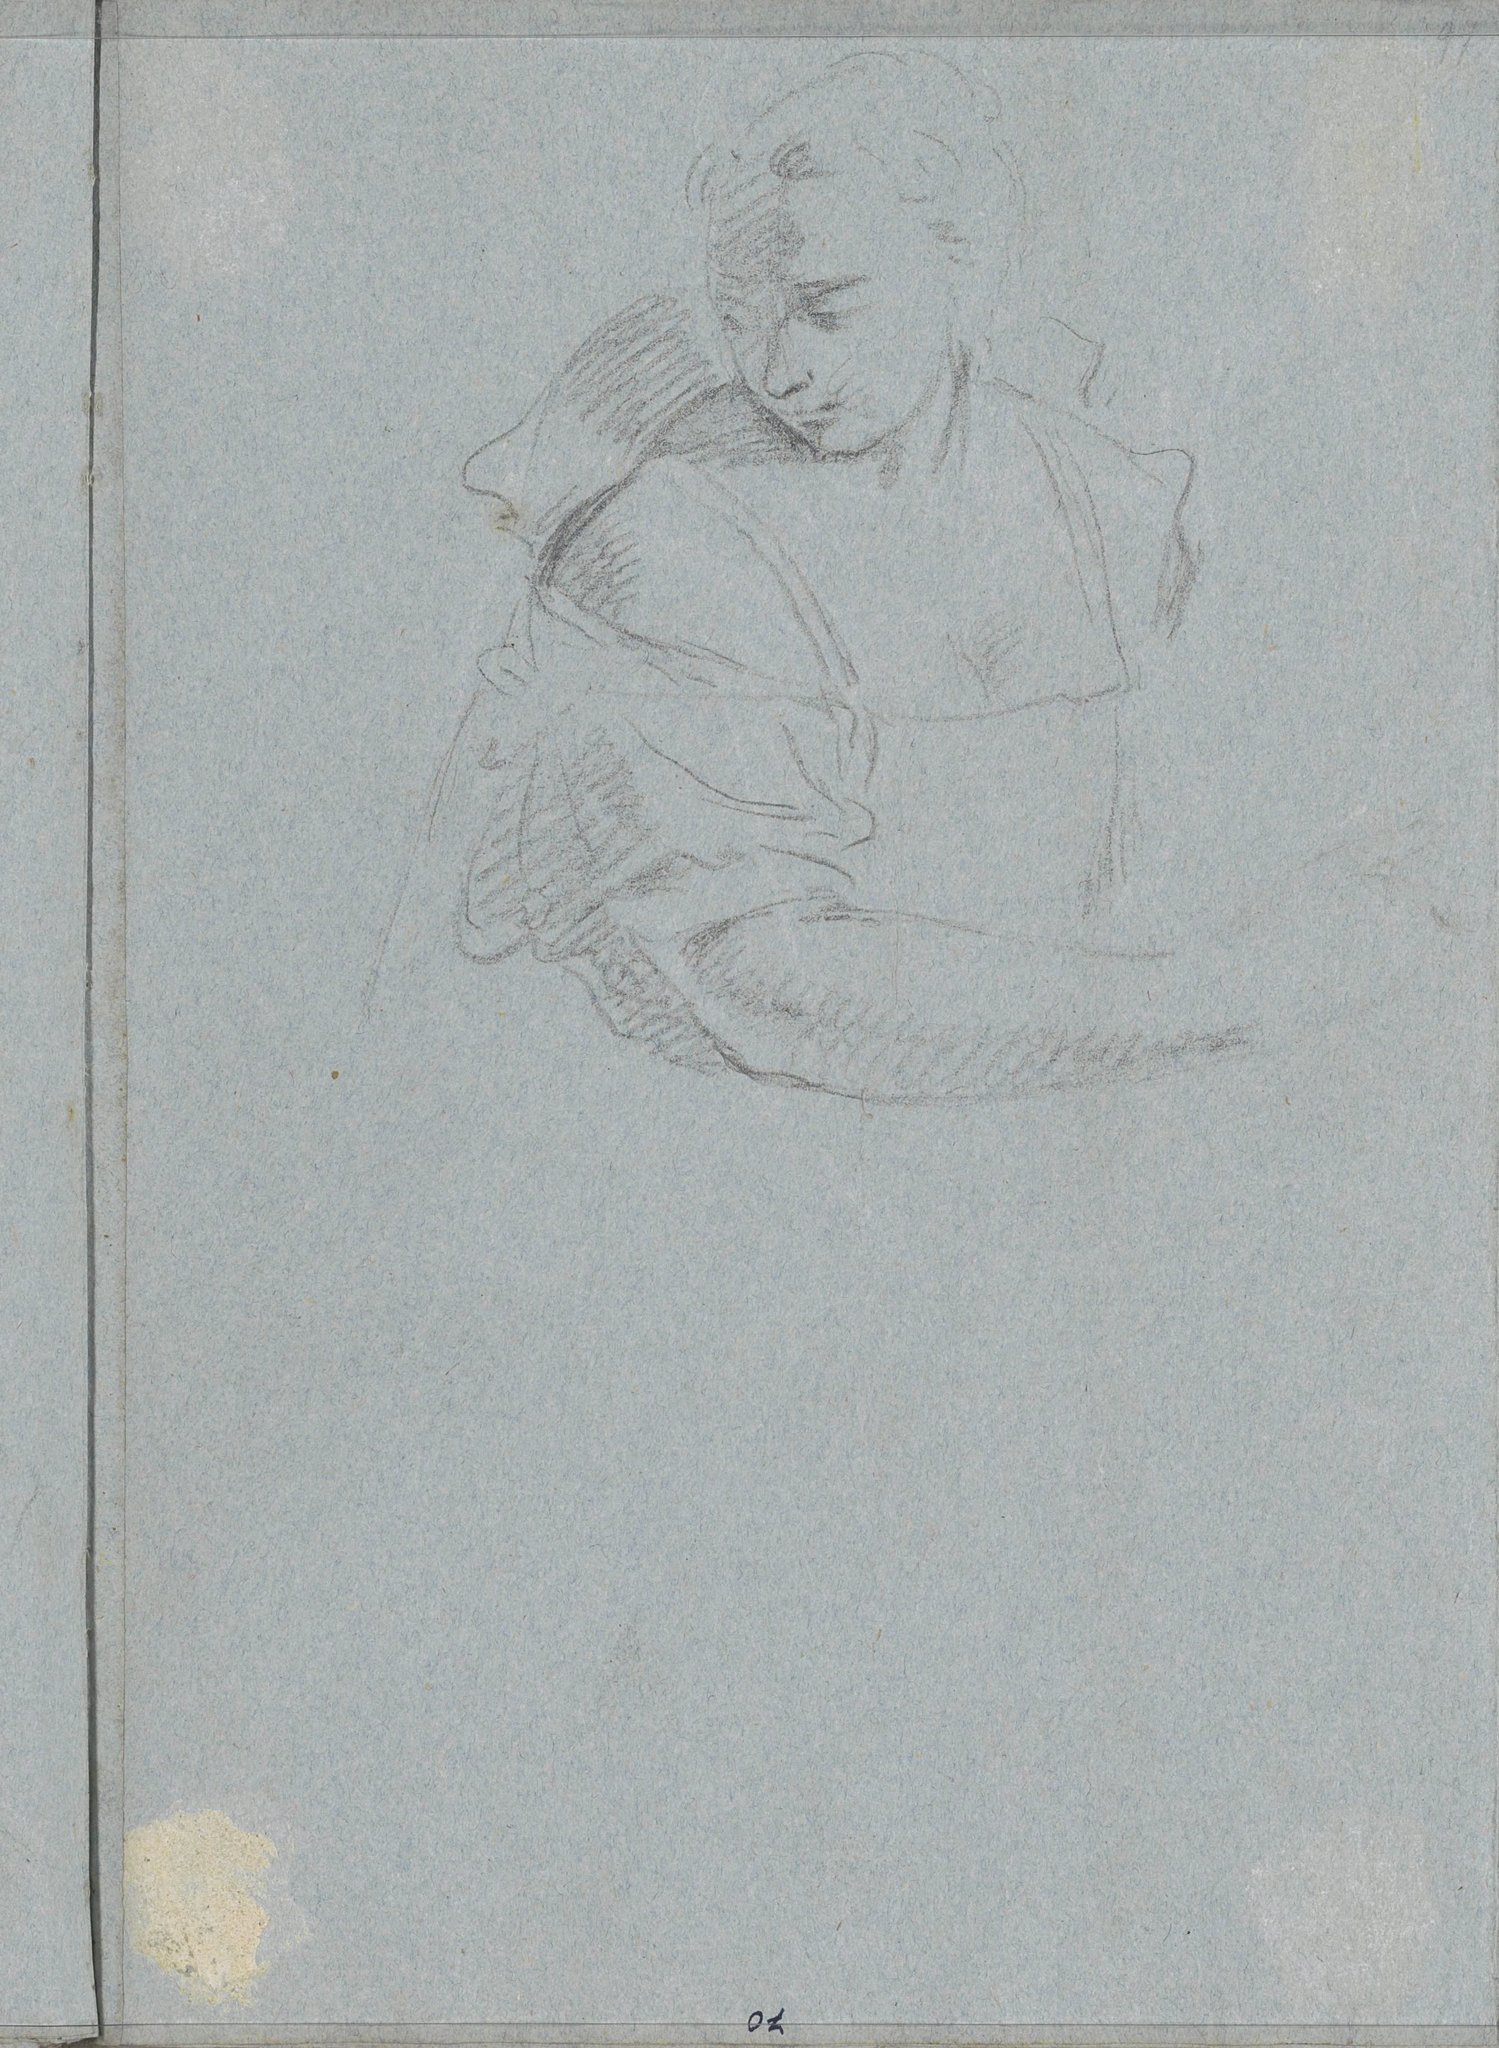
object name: sketchbook leaf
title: Bovenlichaam van een geklede figuur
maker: lorenzo baldissera tiepolo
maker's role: draughtsman, print maker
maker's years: 1736-1776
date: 1751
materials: chalk, paper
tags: clothing for the upper part of the body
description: Bladzijde 97 uit een schetsboek met 158 bladzijden.